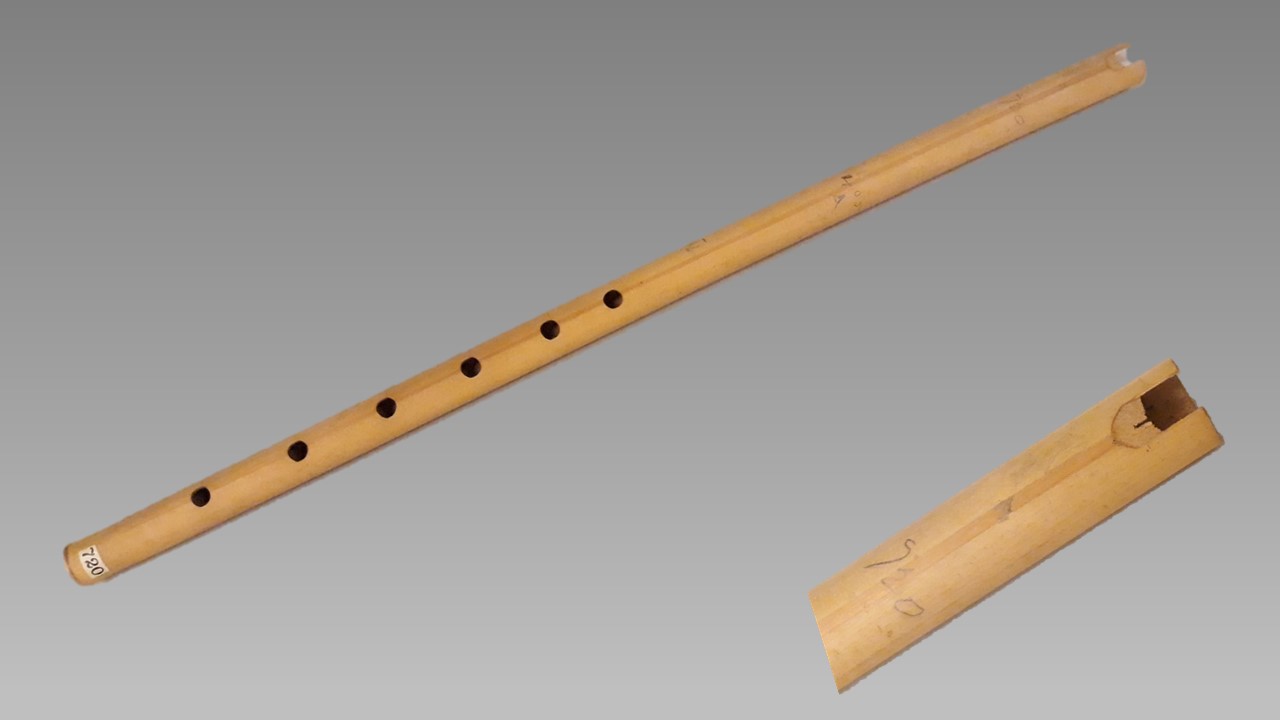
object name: flute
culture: native american or brazilian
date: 1801-1900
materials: bamboo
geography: brazil